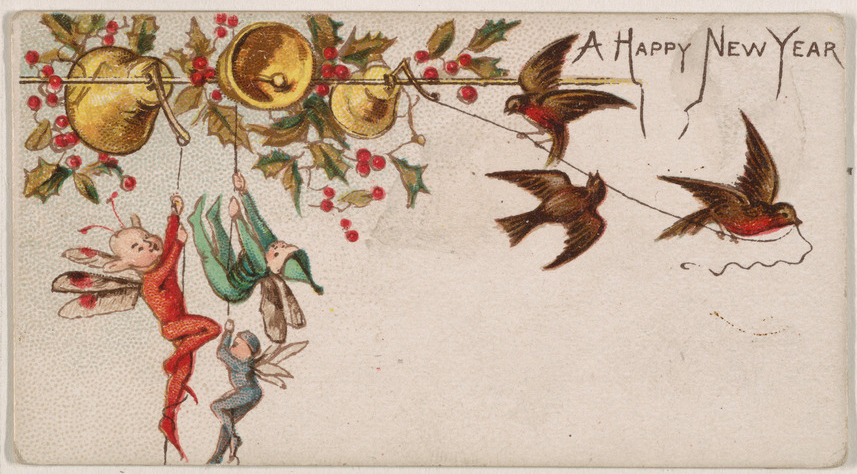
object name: print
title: A Happy New Year, from the New Years 1890 series (N227) issued by Kinney Bros.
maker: kinney brothers tobacco company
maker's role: publisher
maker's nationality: american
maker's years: 1869-2011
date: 1889-1890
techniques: color lithograph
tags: birds,bells